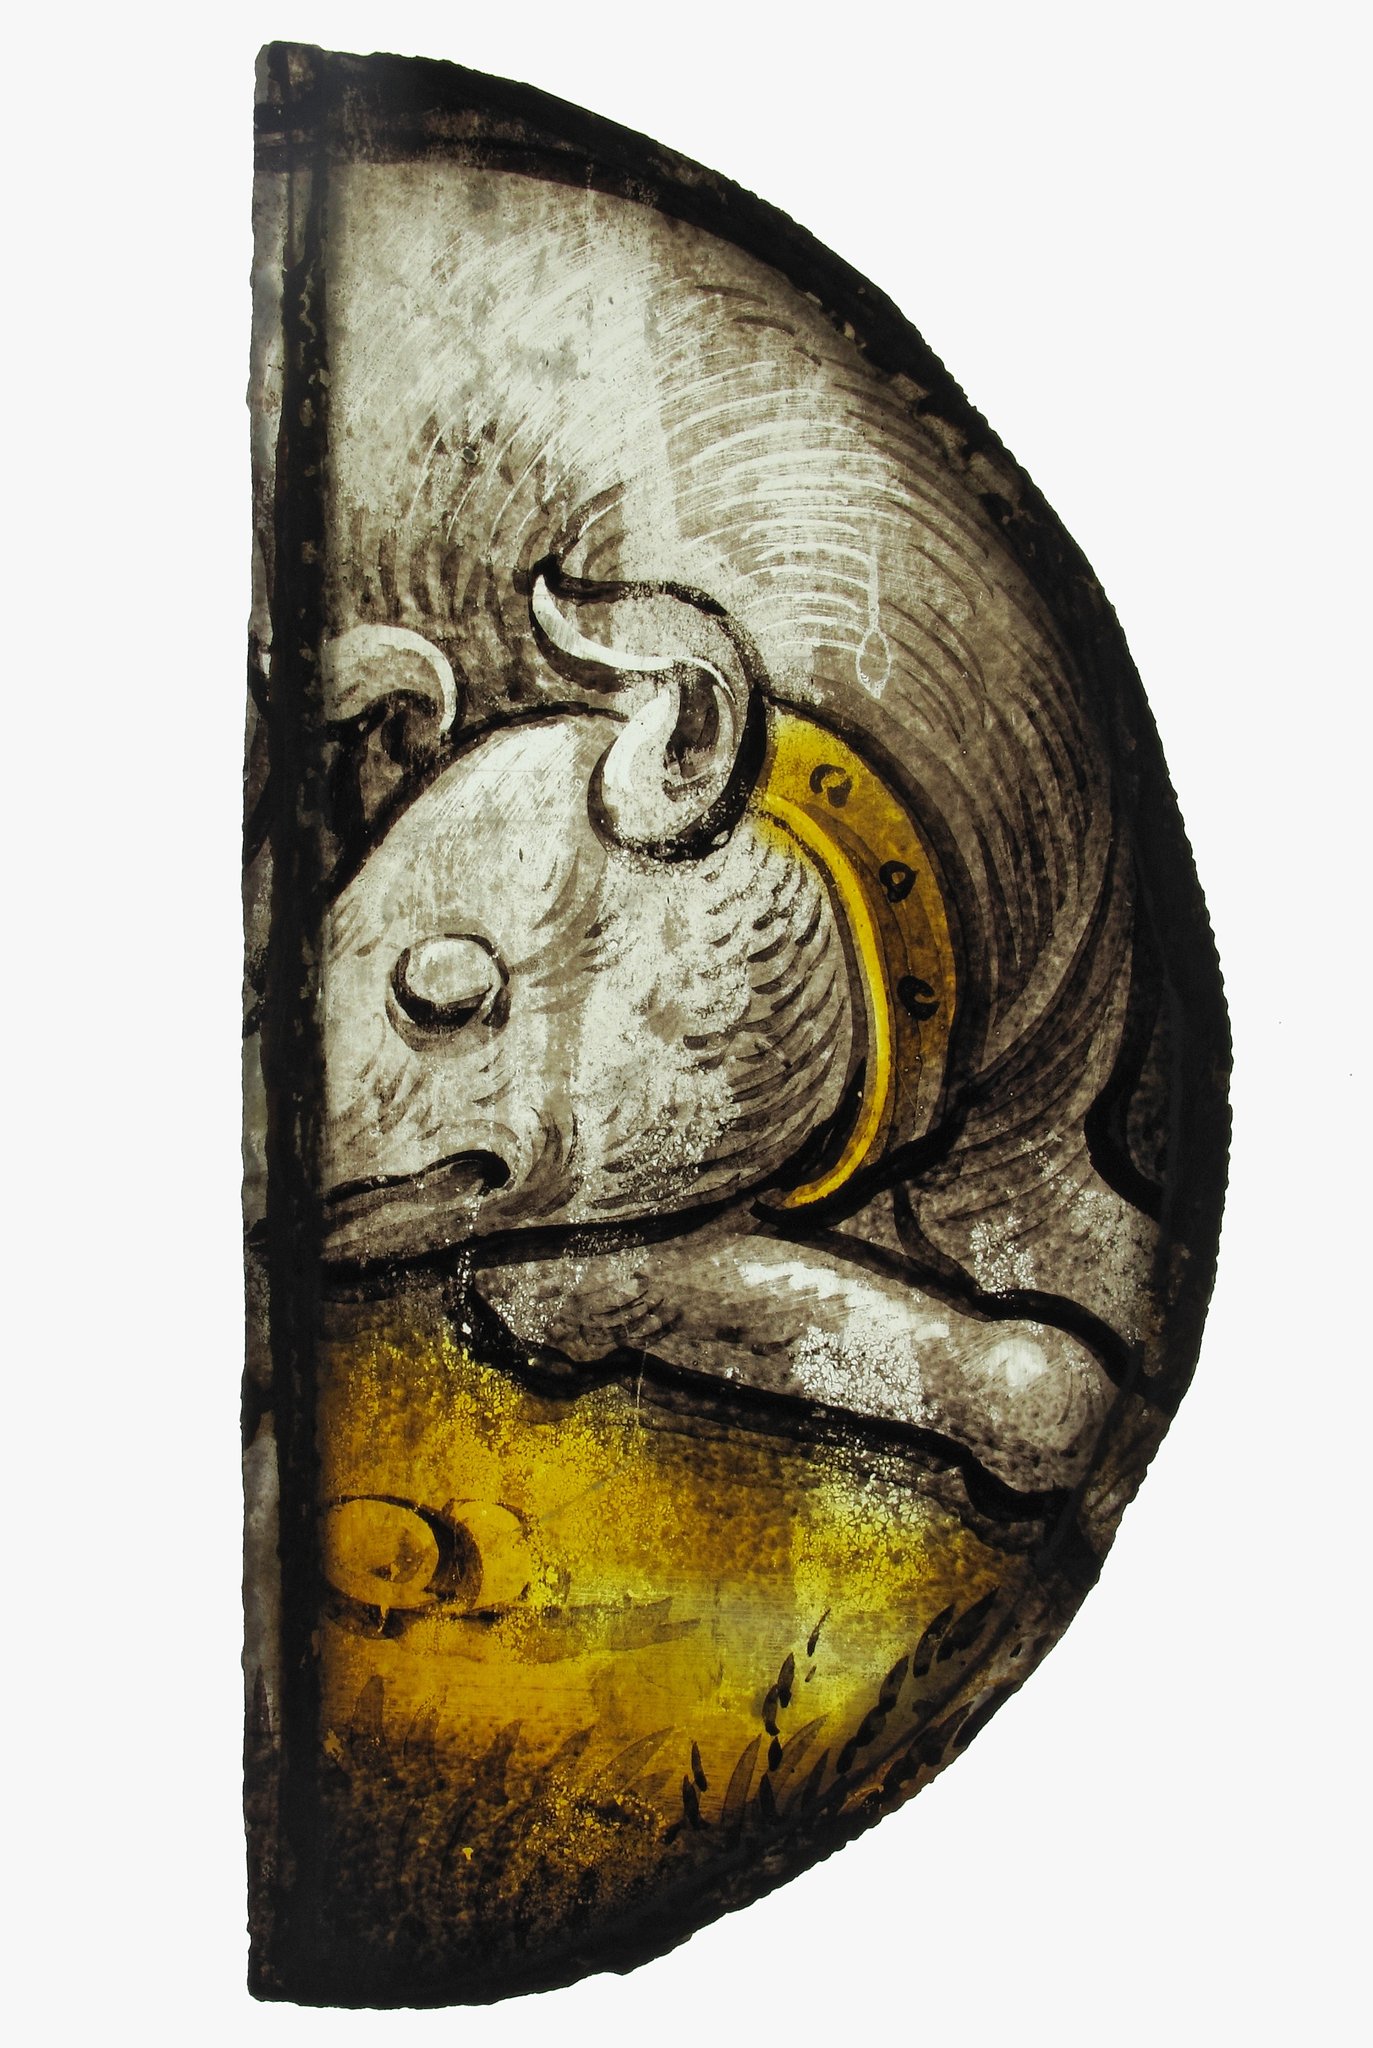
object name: fragment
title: Glass Fragment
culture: european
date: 1401-1600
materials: glass, paint, pigment